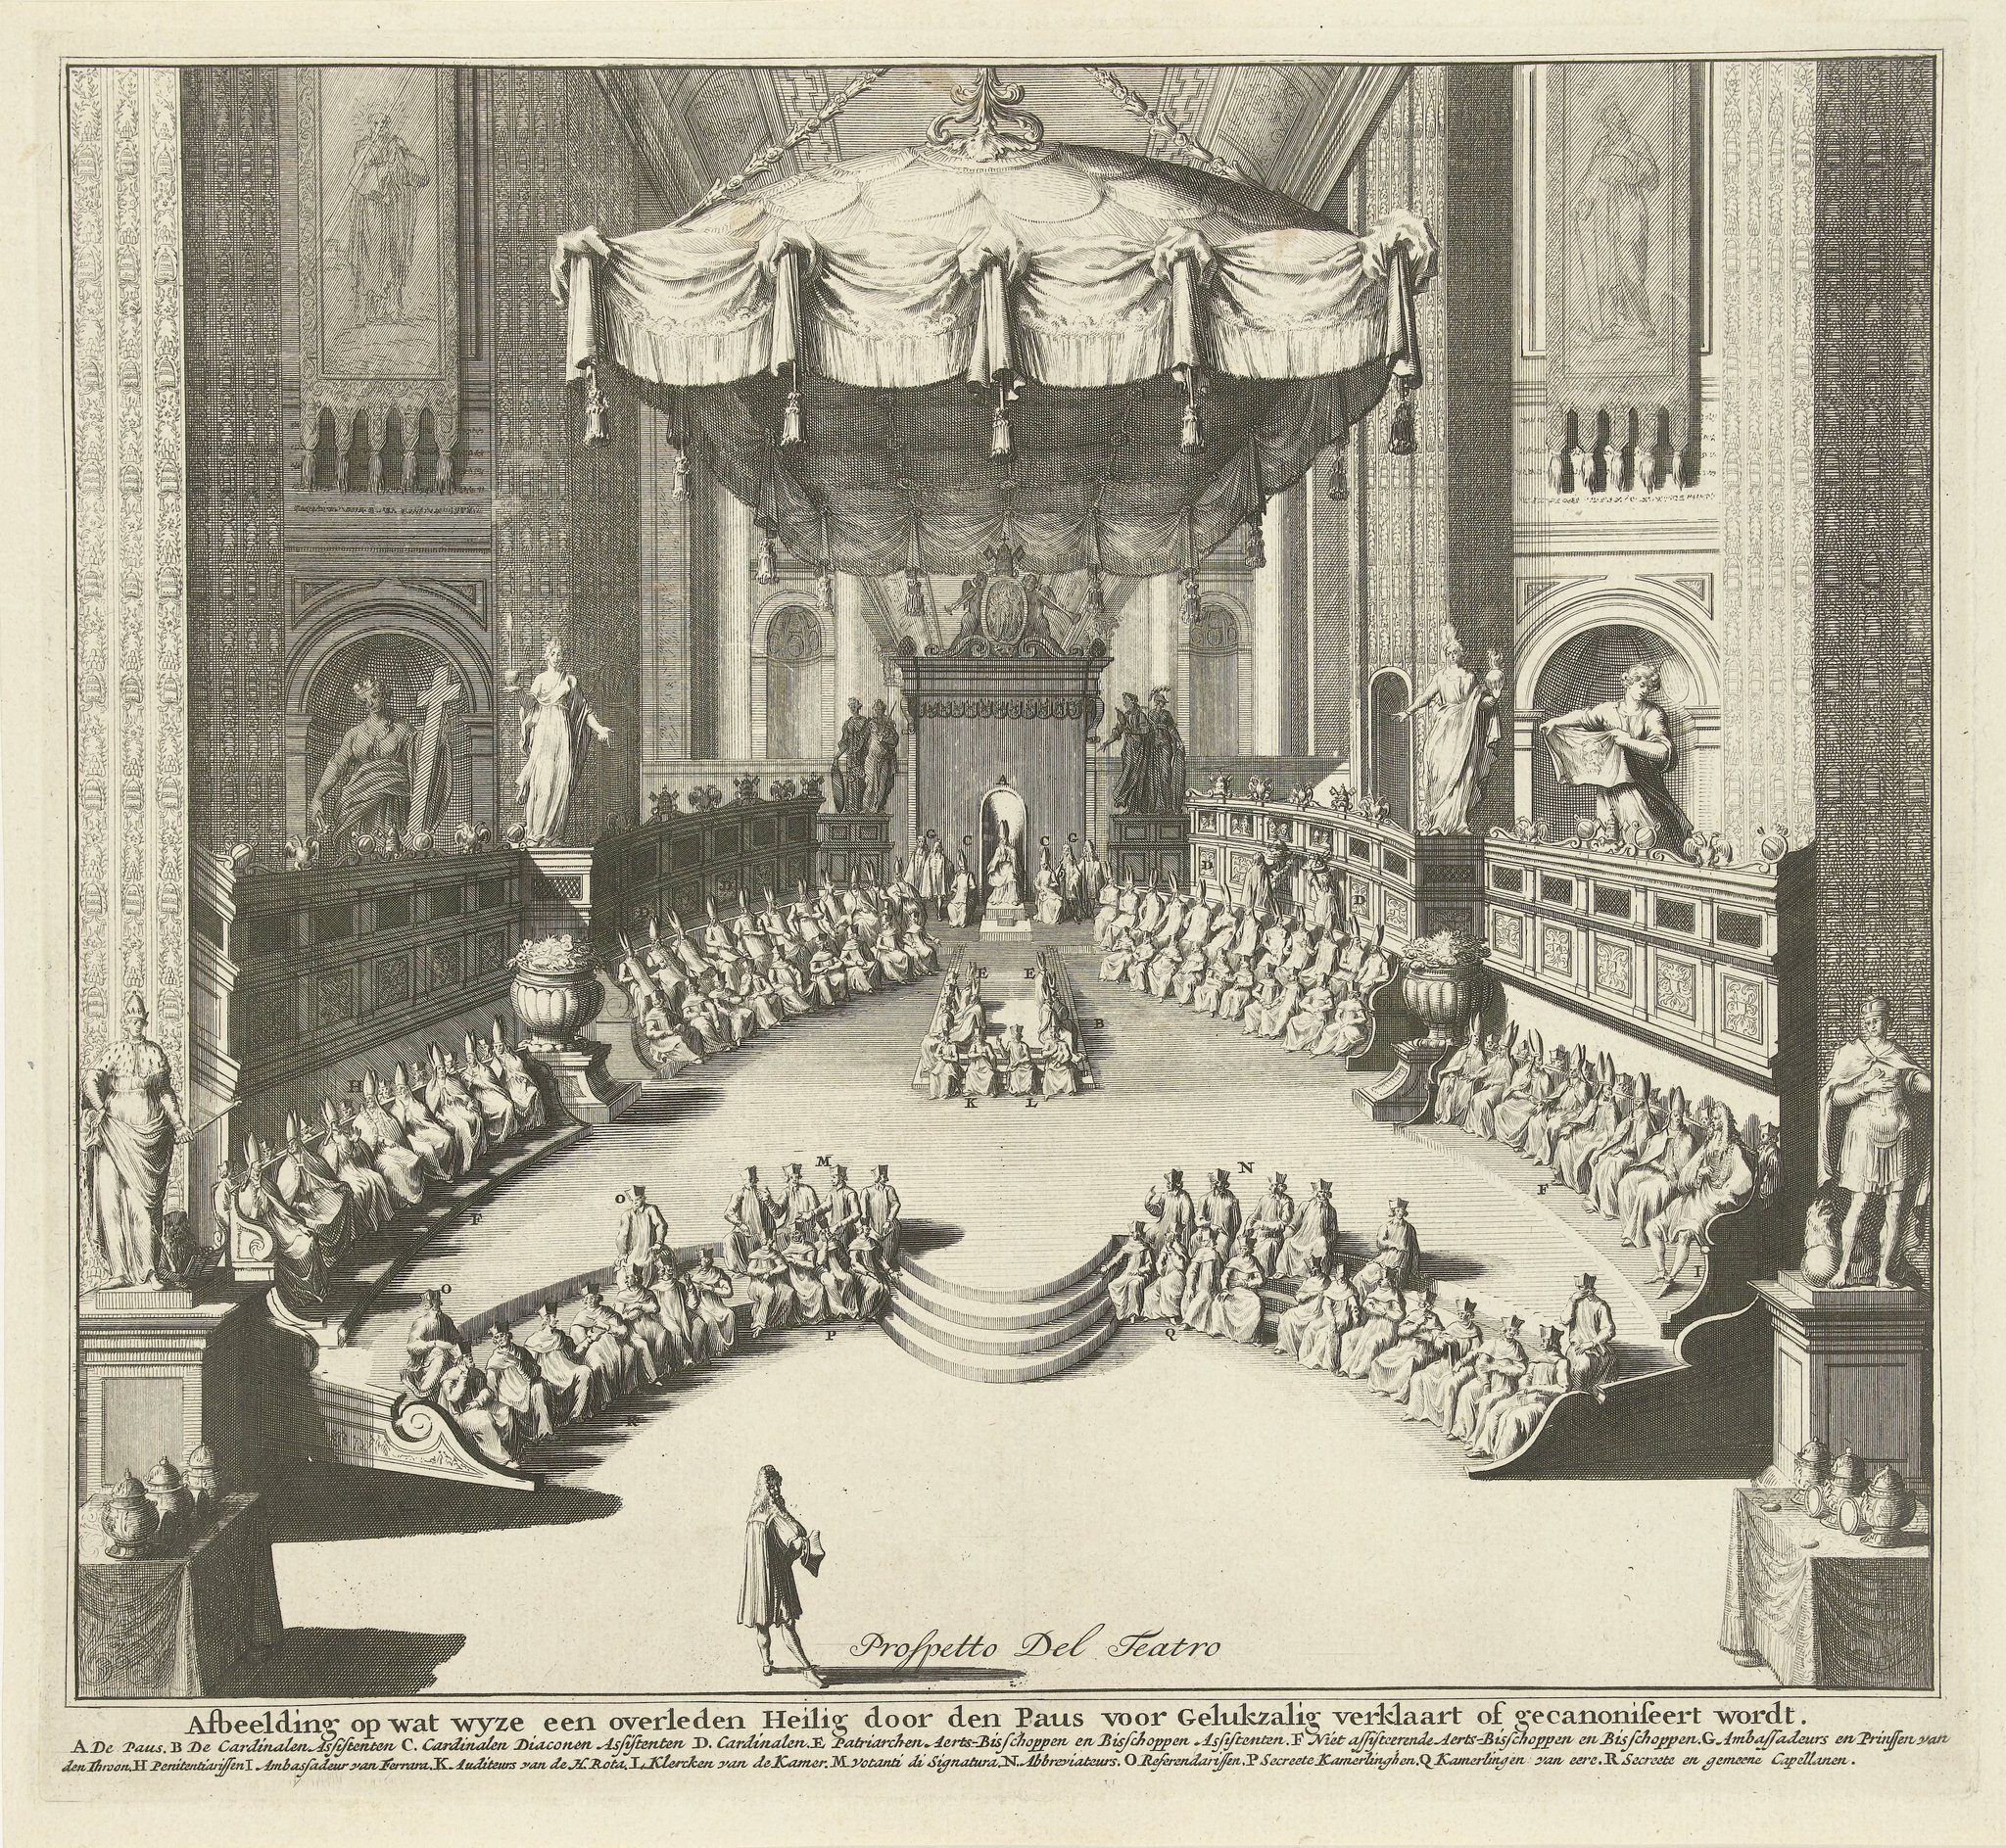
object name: print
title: Collegio di propaganda fide. Zaligverklaring van een heilige en een Conclave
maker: hendrik elandt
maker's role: print maker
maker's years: -1705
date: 1700-1705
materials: paper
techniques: engraving, etching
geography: amsterdam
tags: ceremonial celebrations ~ pope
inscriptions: collector's mark: Lugt 2228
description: Weergave van het interieur van het Collegio di Propaganda Fide met alle aanwezigen tijdens een zaligverklaring. Centraal in de ronde nis zetelt de paus. Onder de voorstelling worden in drie regels in het Nederlands en Latijn, de verschillende afgebeelde groepen mensen geïndentificeerd.